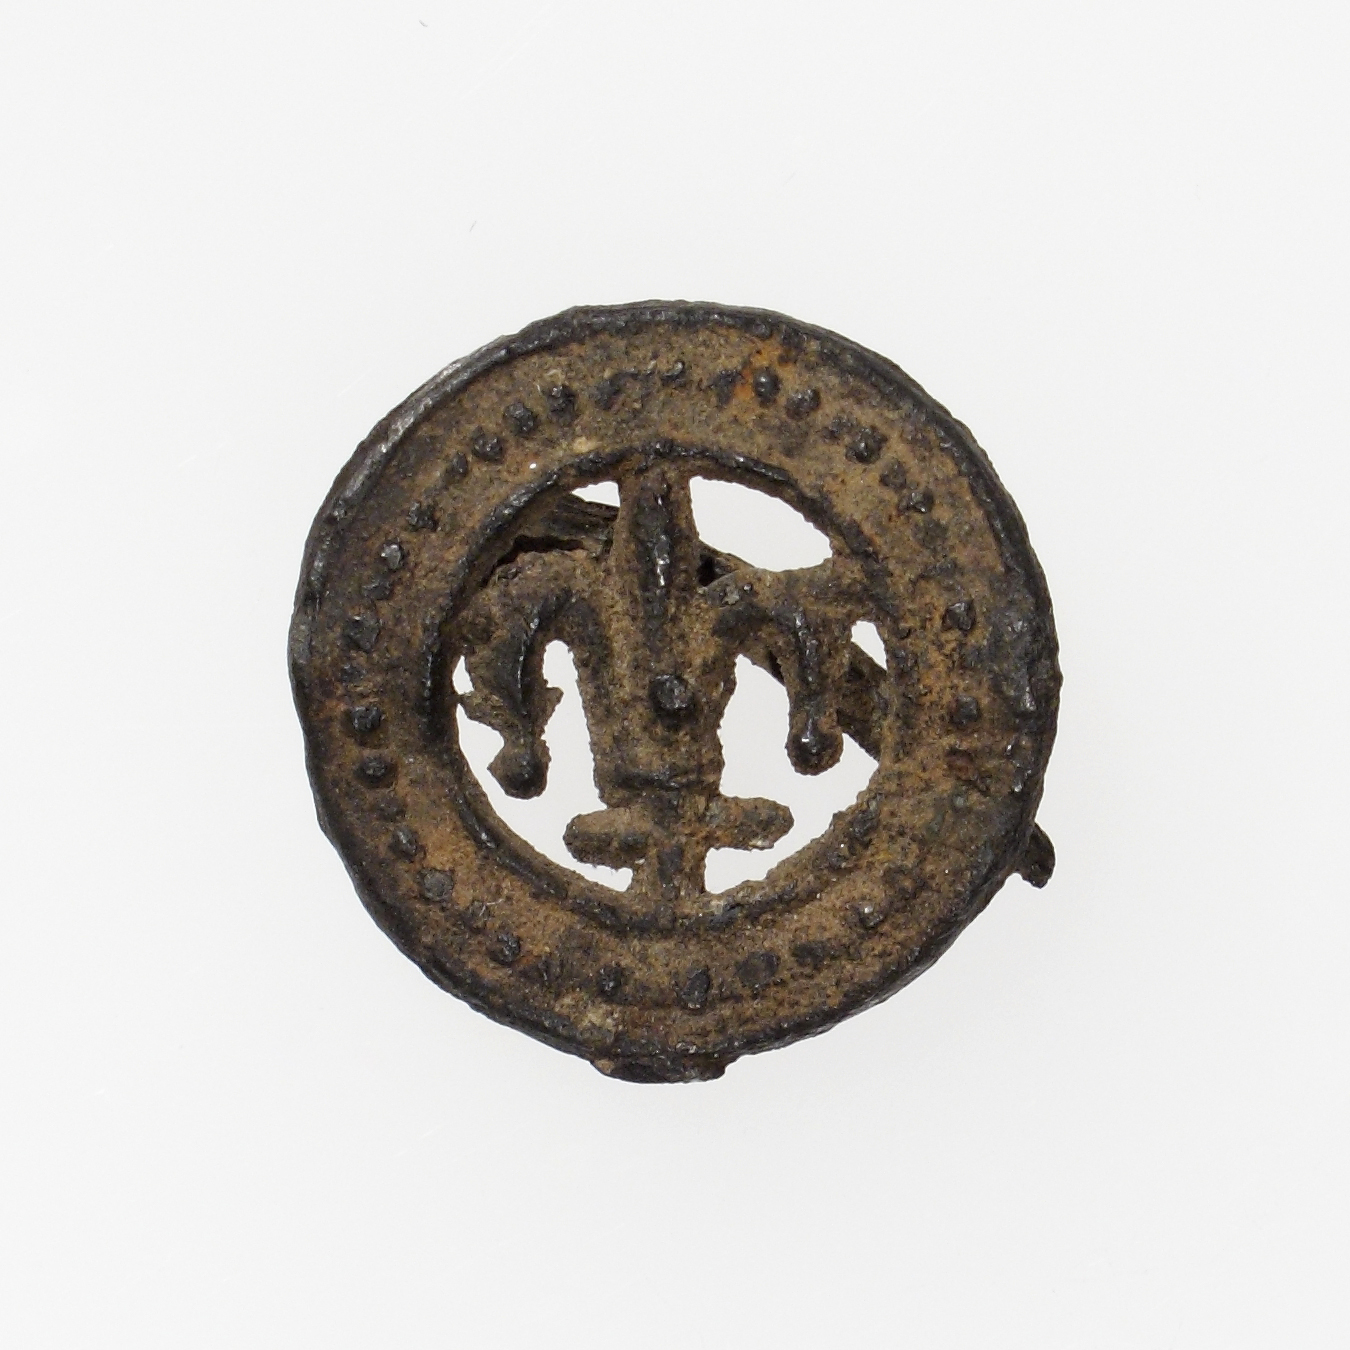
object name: pilgrim's badge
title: Pilgrim's Badge in the form of a Ring brooch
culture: french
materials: lead